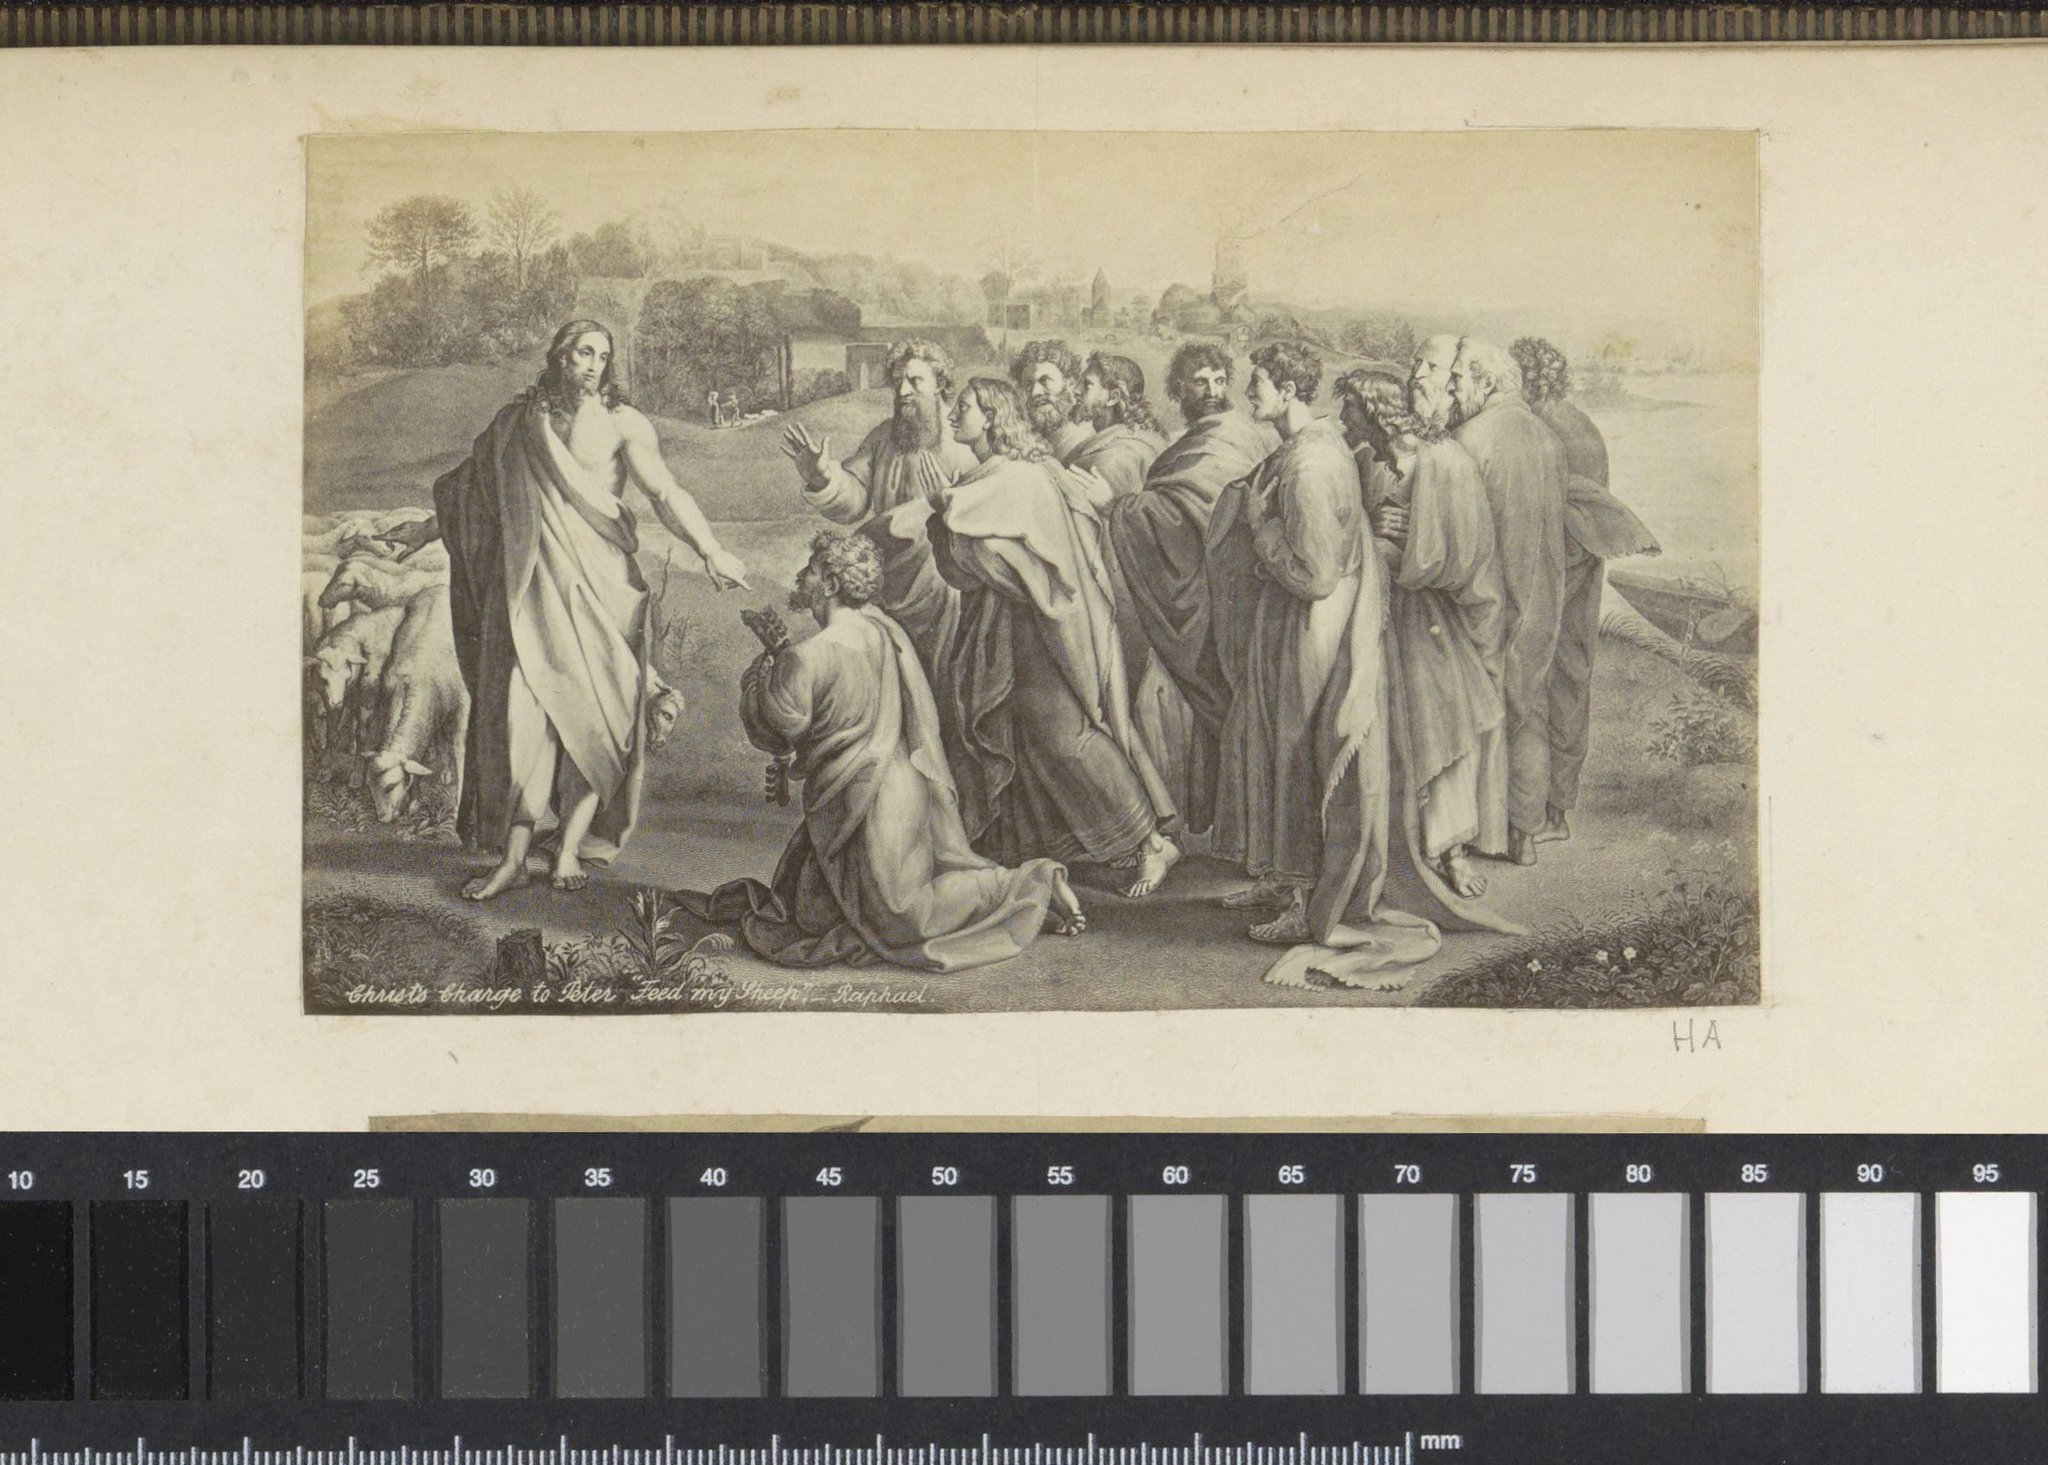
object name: photograph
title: Christ's Charge to Peter "Feed my Sheep". Raphael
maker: Anonymous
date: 1850-1870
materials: paper, photographic support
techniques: albumen print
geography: england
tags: mission of peter ('pasce oves meas'): christ pointing to a lamb, peter perhaps with keys in his hands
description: Onderdeel van Album met foto's van bezienswaardigheden en landschappen in Engeland en van kunst.